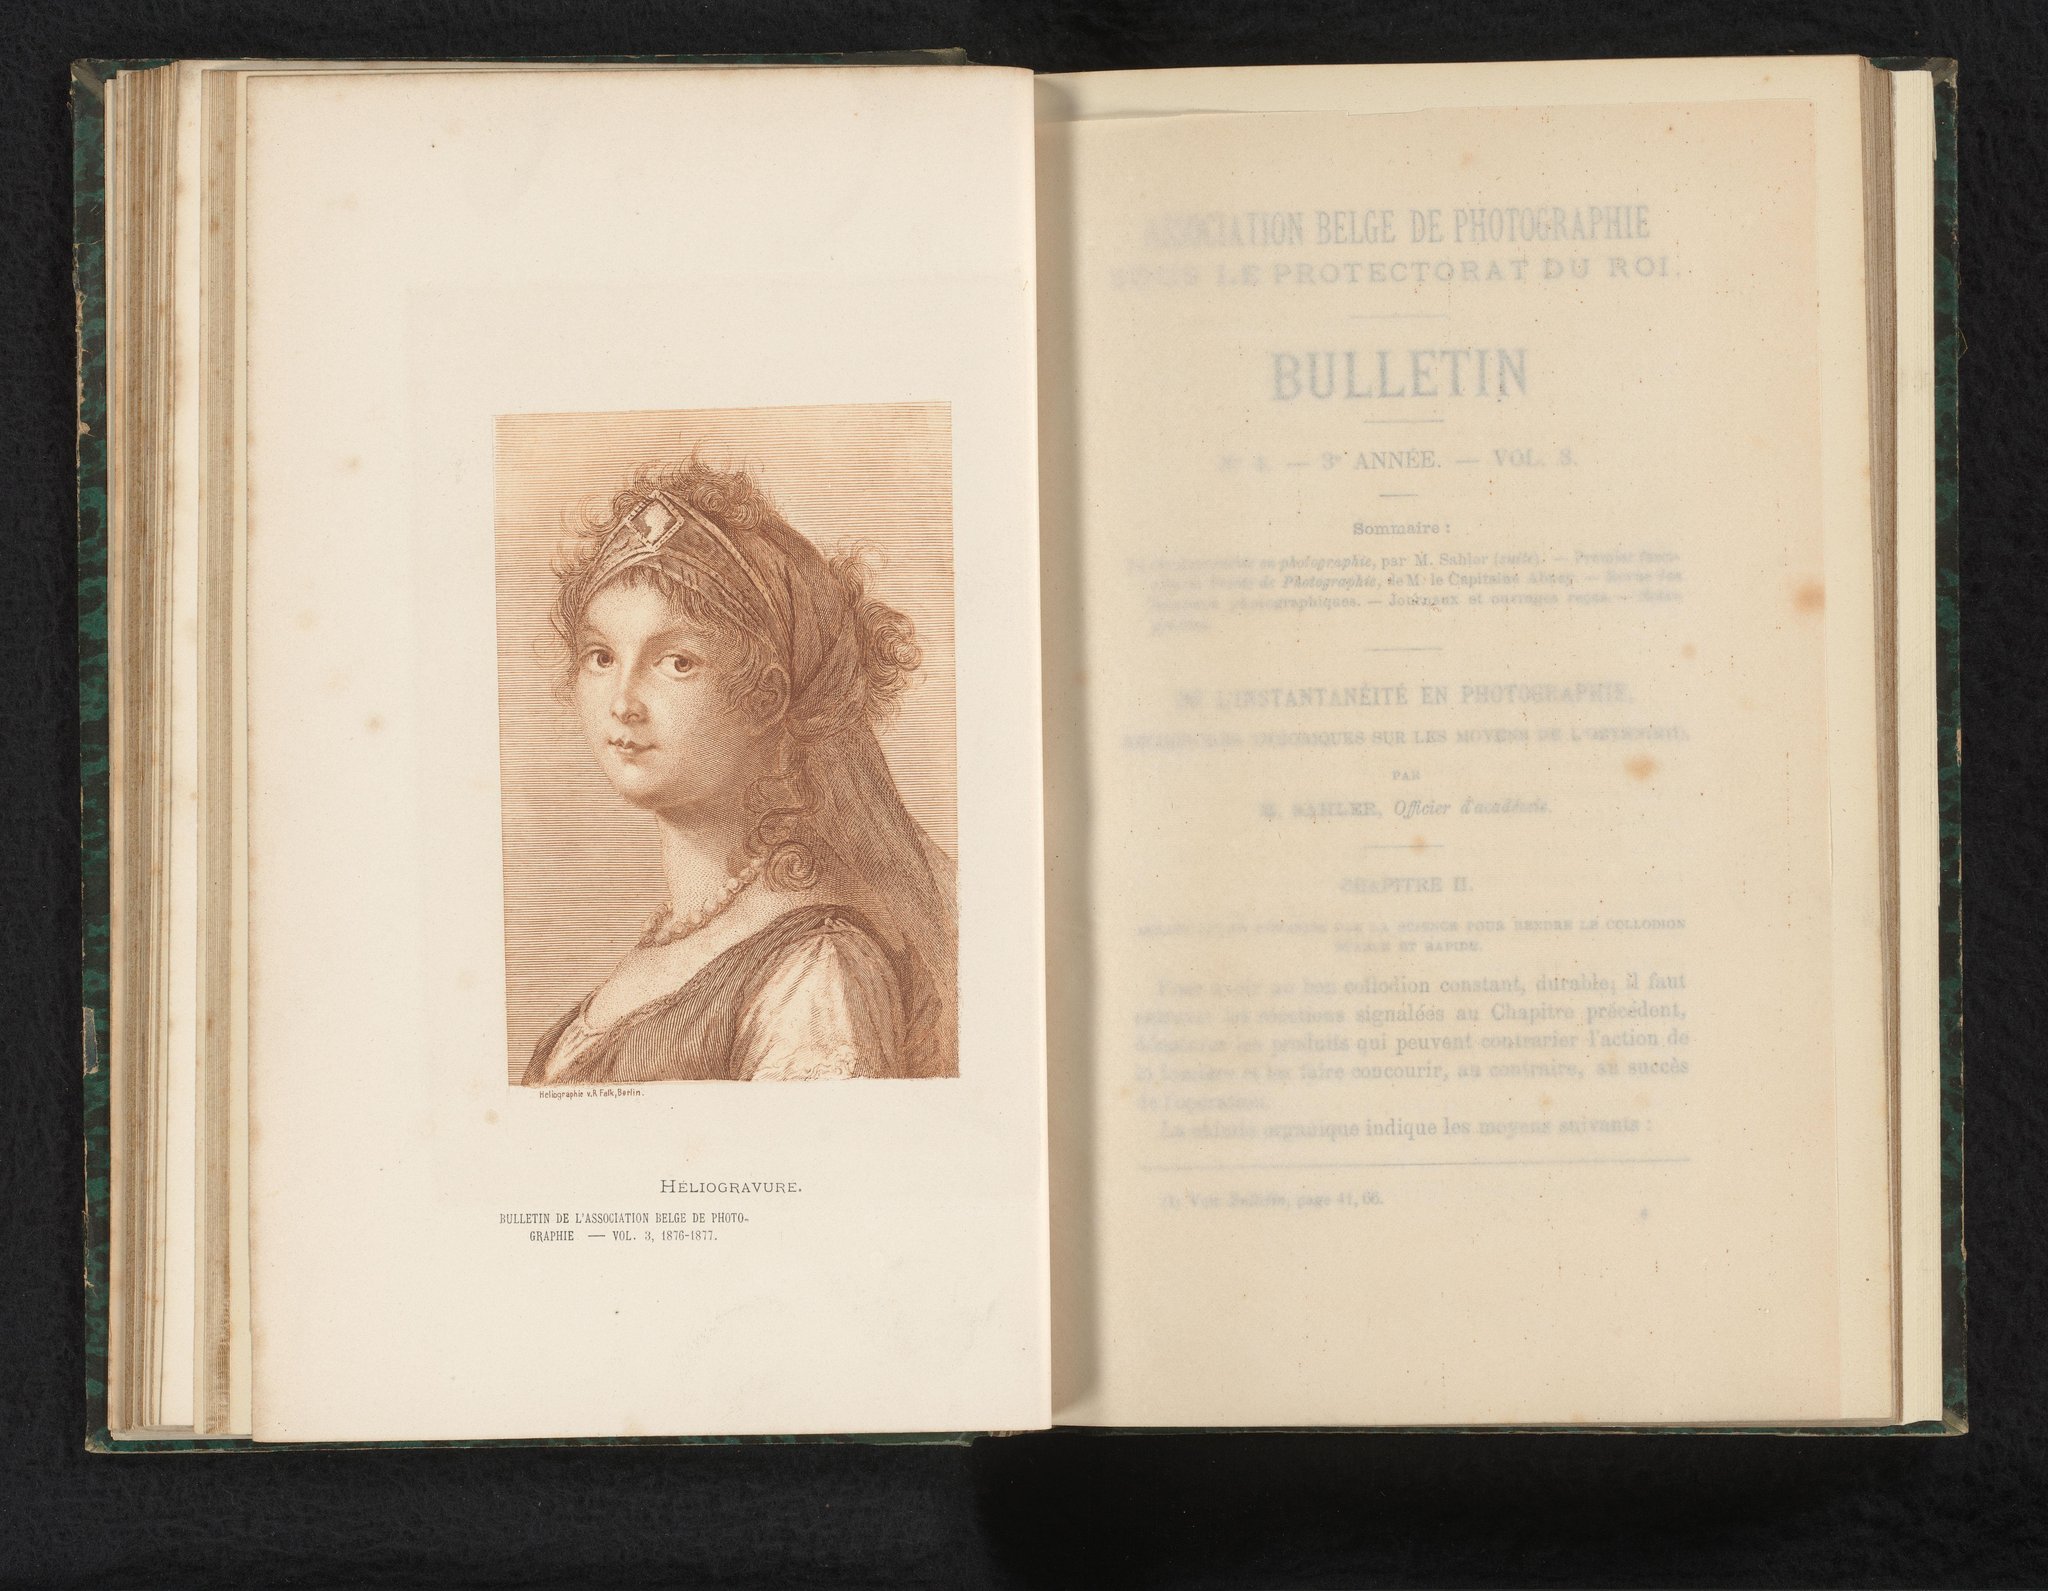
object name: page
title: Königin Louise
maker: richard falk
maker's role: clichémaker, fotograaf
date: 1876-1877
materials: paper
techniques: photoaquatint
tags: historical persons - bb - woman, queen, empress, etc. (wife of a ruler)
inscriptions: inscription: ‘Héliogravure’